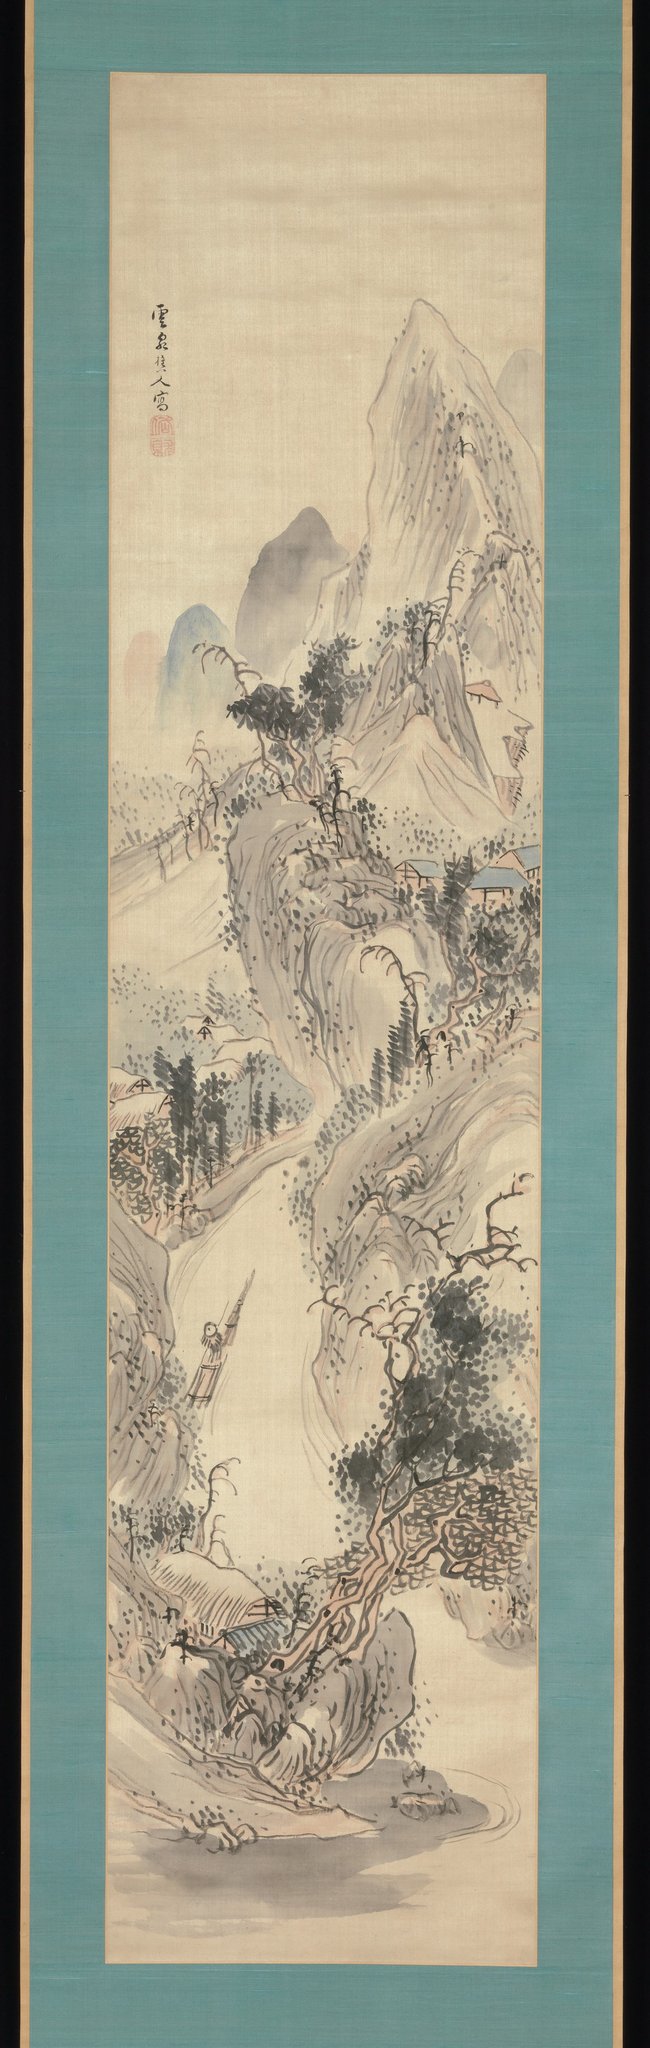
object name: hanging scroll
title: Landscape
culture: japanese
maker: kushiro unsen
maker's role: artist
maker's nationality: japanese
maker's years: 1759-1811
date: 1701-1900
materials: ink, textile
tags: landscapes